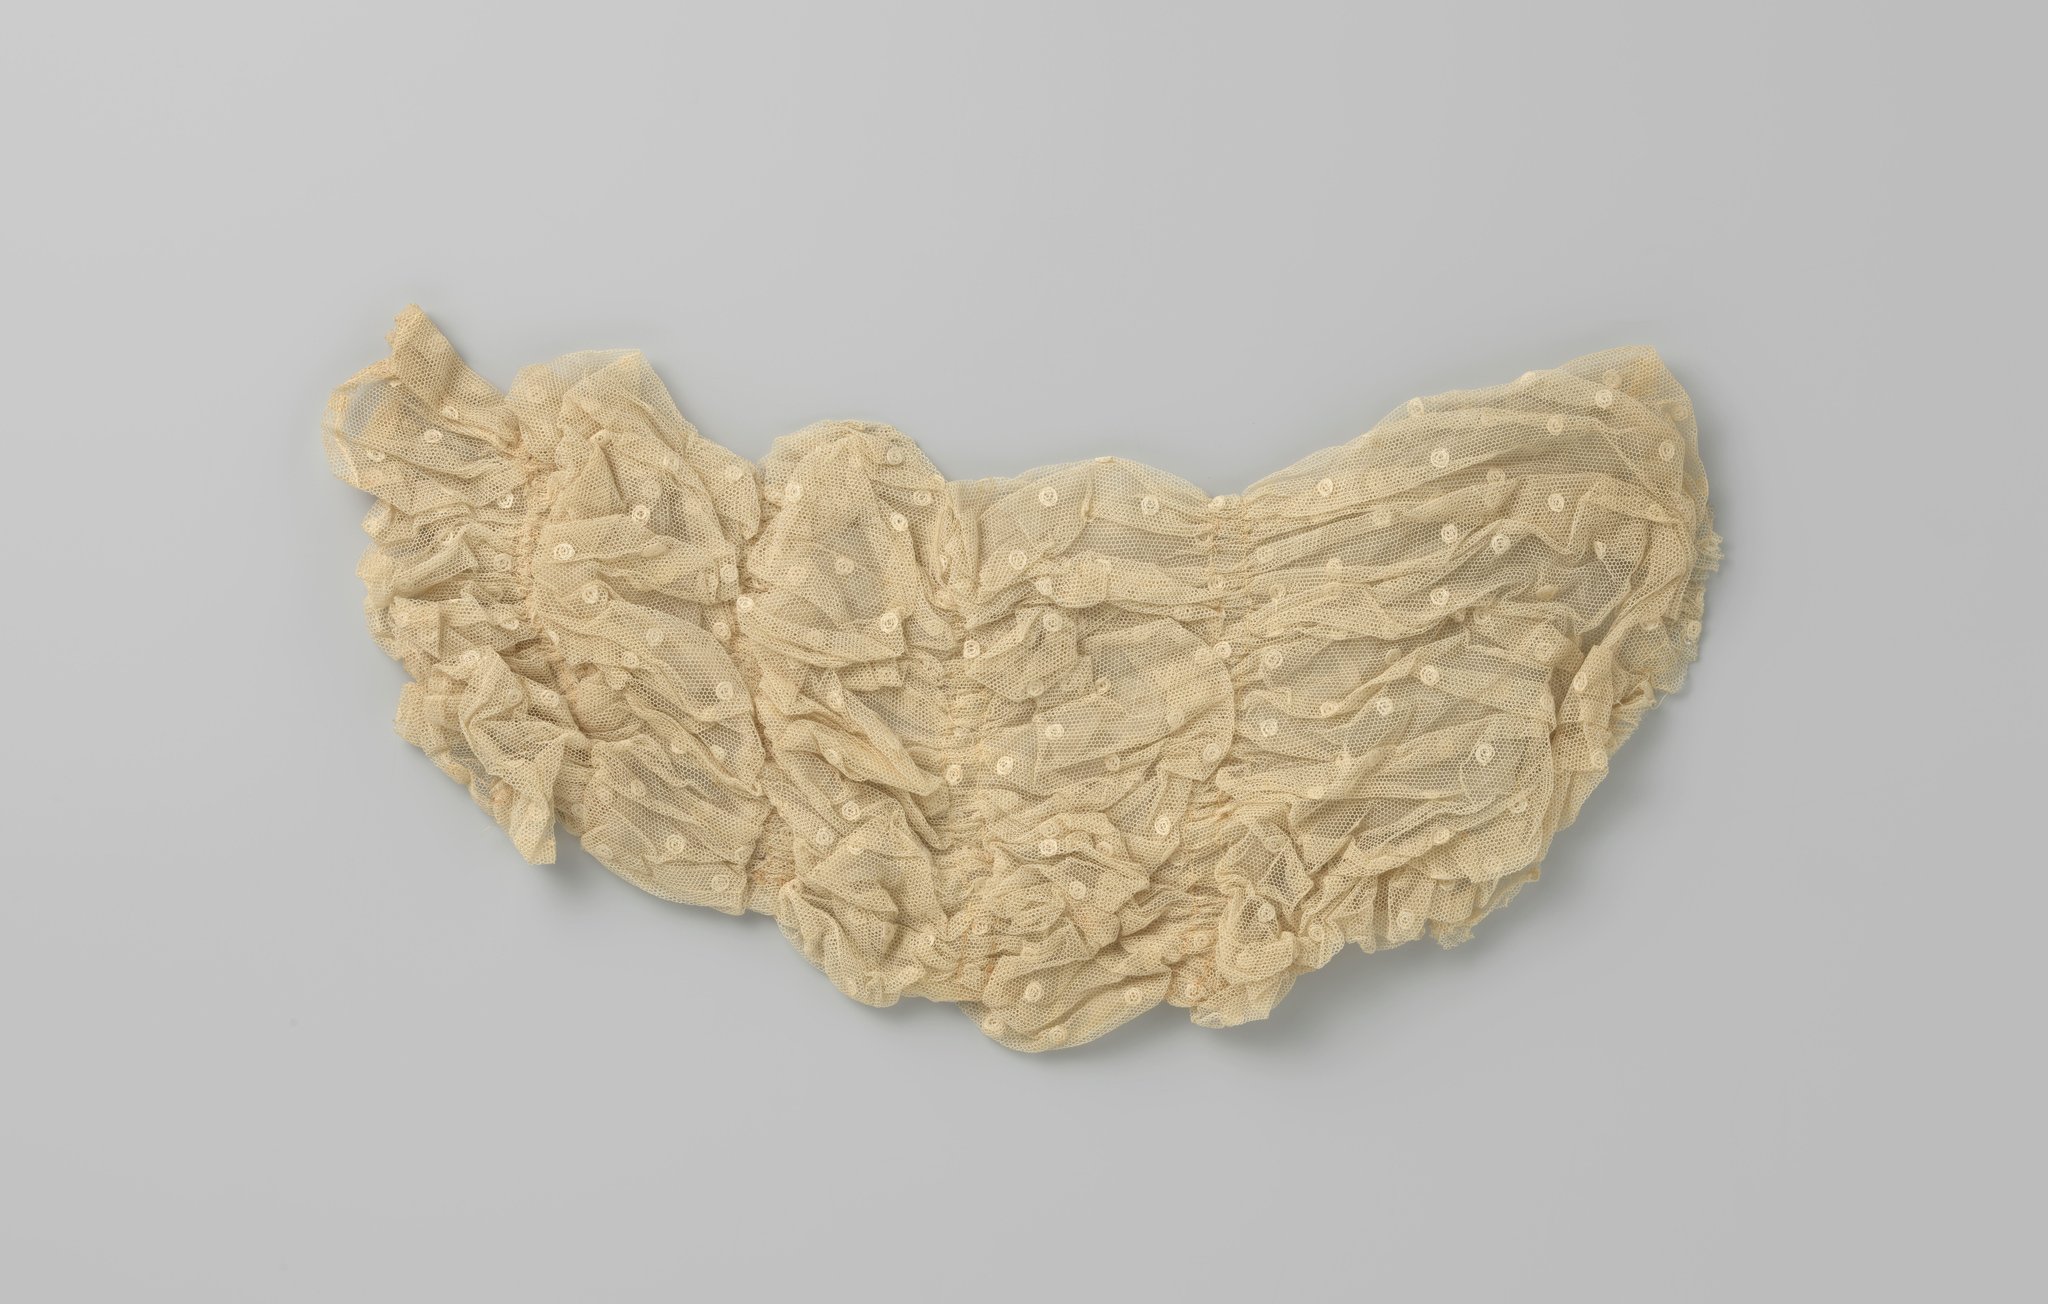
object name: womenswear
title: Mouw van witte tule met moesjes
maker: Anonymous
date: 1800-1900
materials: fiber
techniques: embroidered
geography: europe